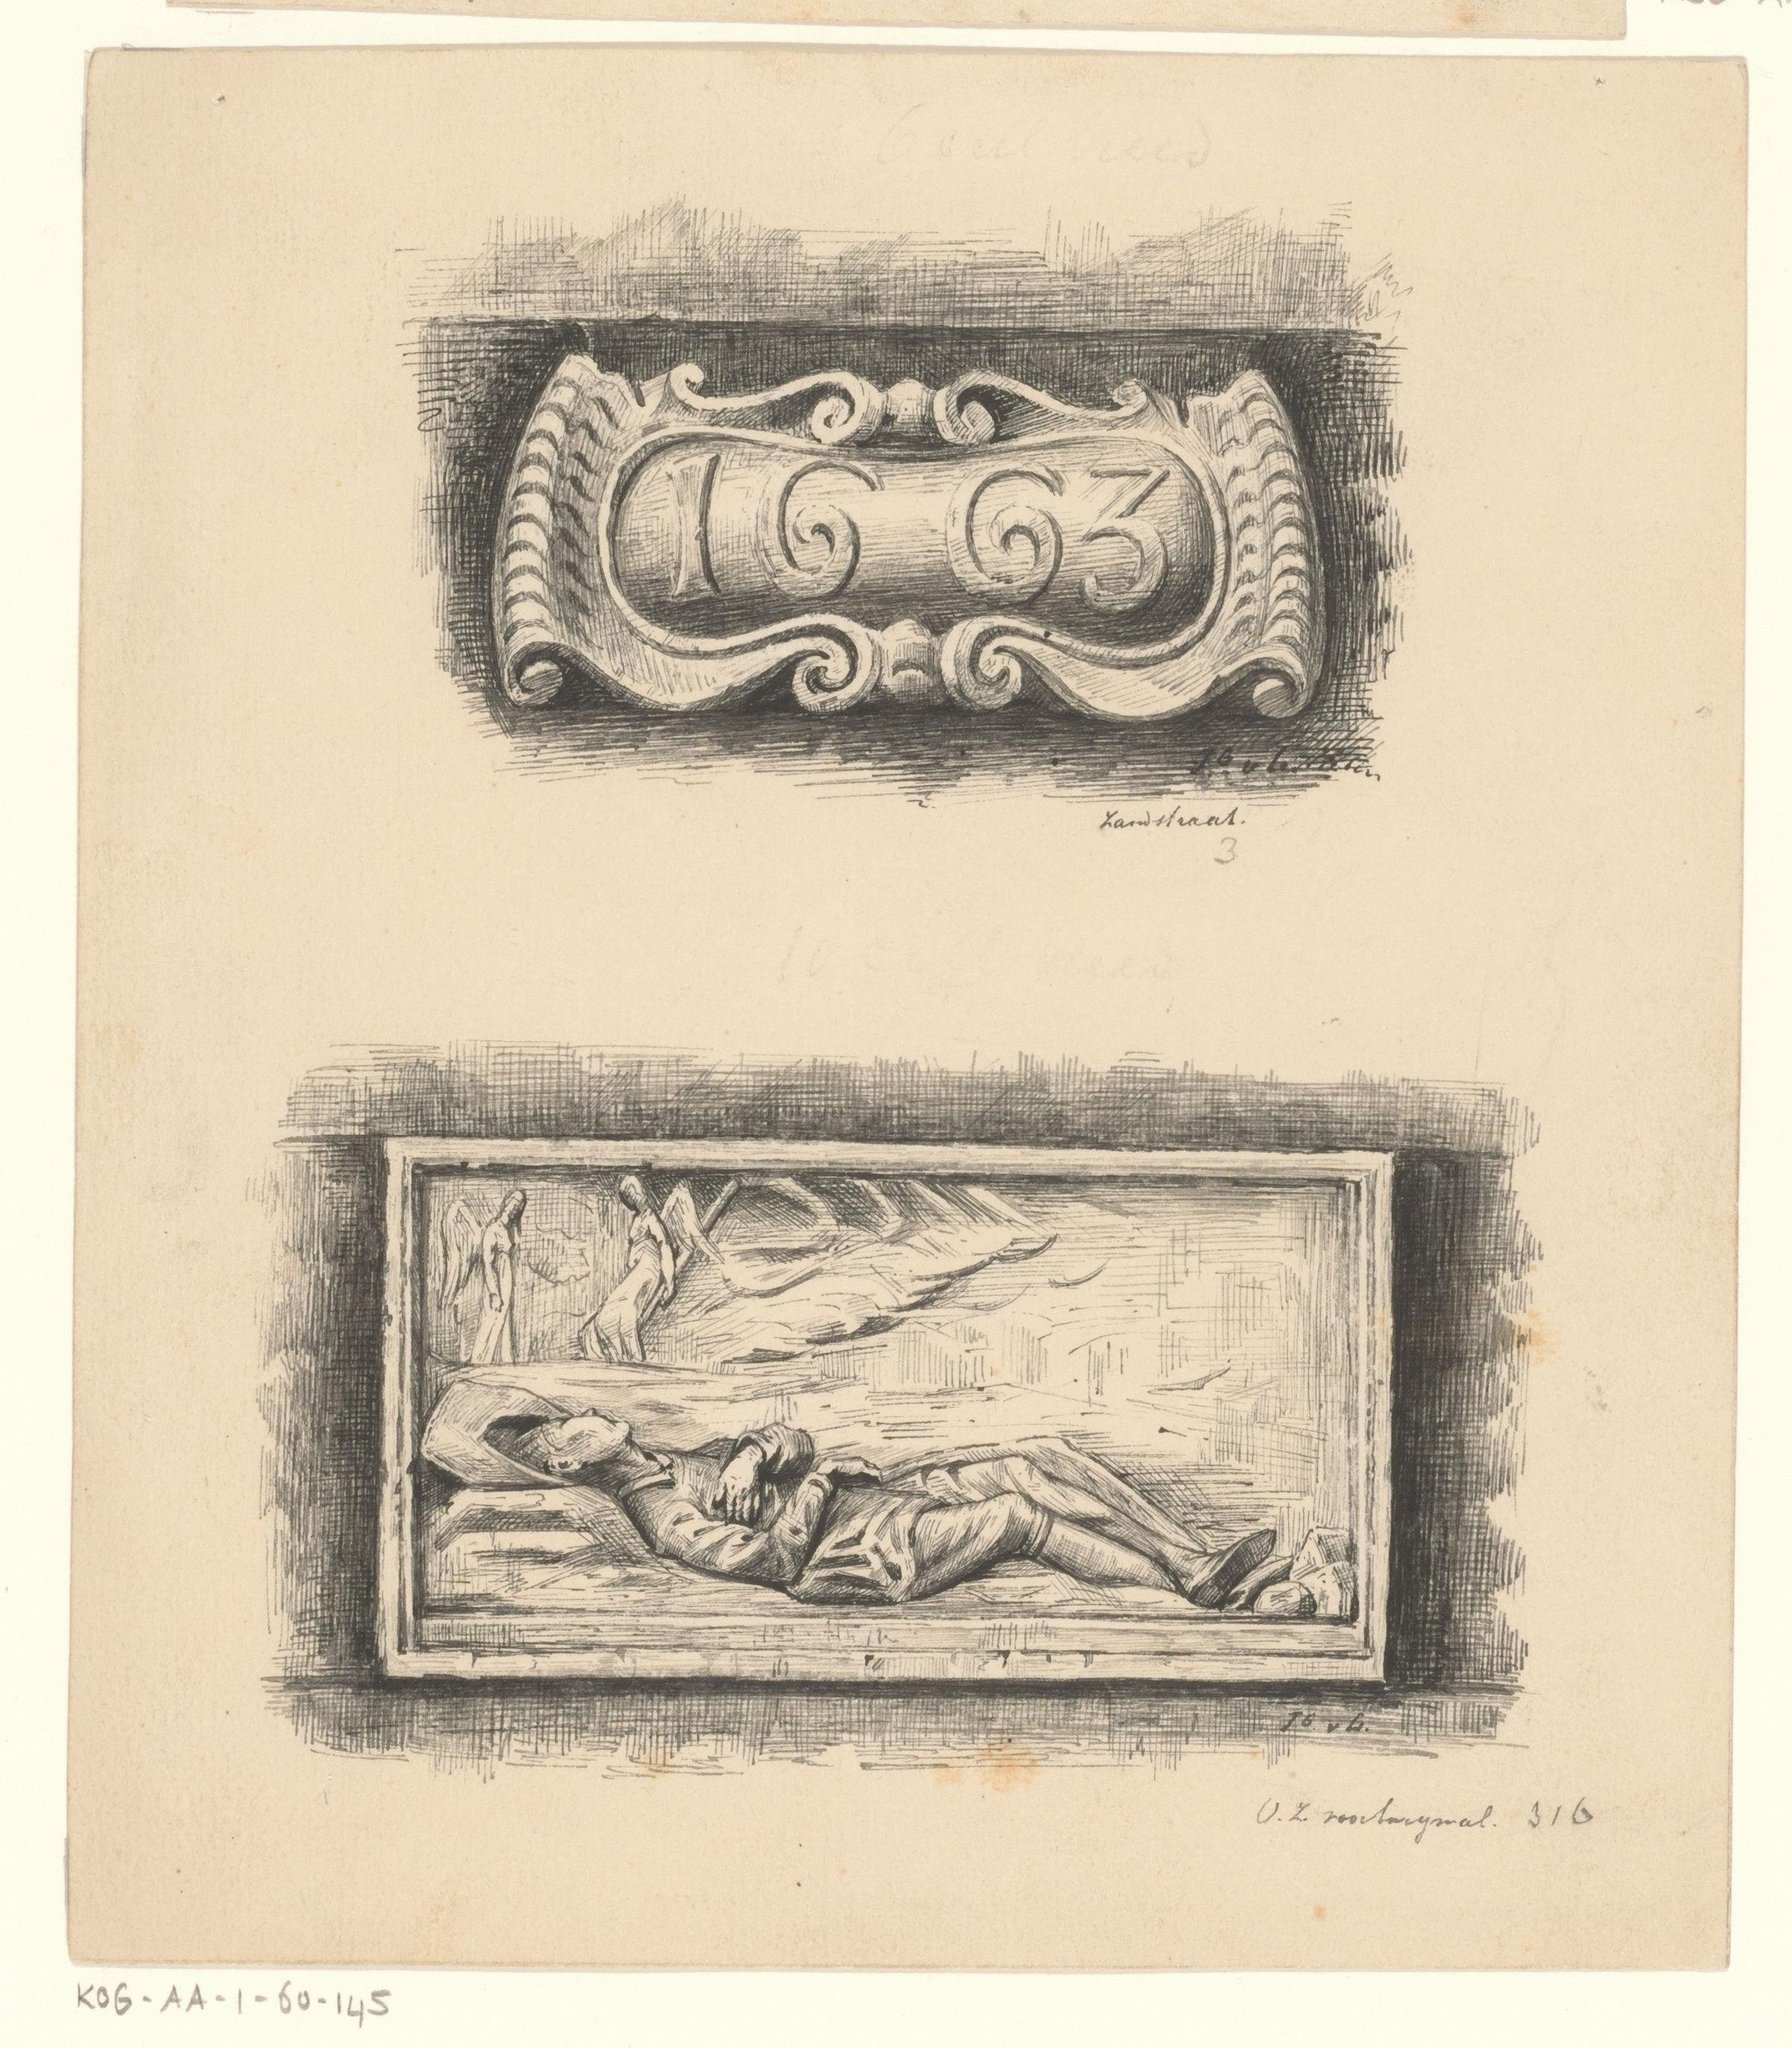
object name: drawing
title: Compositie met gevelstenen in de Zandstraat 31b en de Oudezijds Voorburgwal 3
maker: jac van looij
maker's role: draughtsman, painter, print maker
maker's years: 1855-1930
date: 1865-1930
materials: ink, paper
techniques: brush, pen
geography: amsterdam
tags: stone tablet in façade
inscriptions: signature: ‘Jb. v L’, inscription: ‘Zandstraat./ O.Z. voorburgwal.’, collector's mark: ‘60 145’ Lugt 1641b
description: Onderwerpsrubriek binnen de Atlas Amsterdam: Beeldhouwkunst - Gevelstenen.